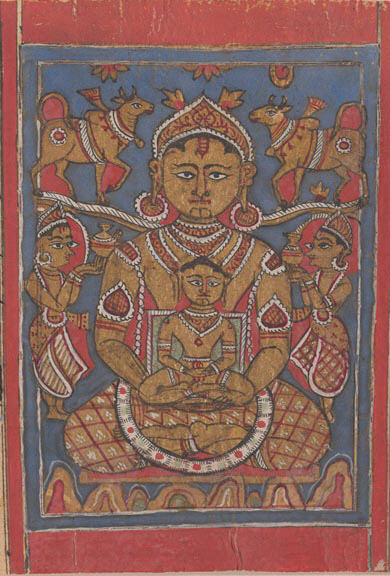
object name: folio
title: Mahavira's Lustration and Bath at Birth; Page from a Dispersed Kalpa Sutra (Jain Book of Rituals)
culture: indian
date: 1401-1500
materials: gold, ink, paper, watercolor